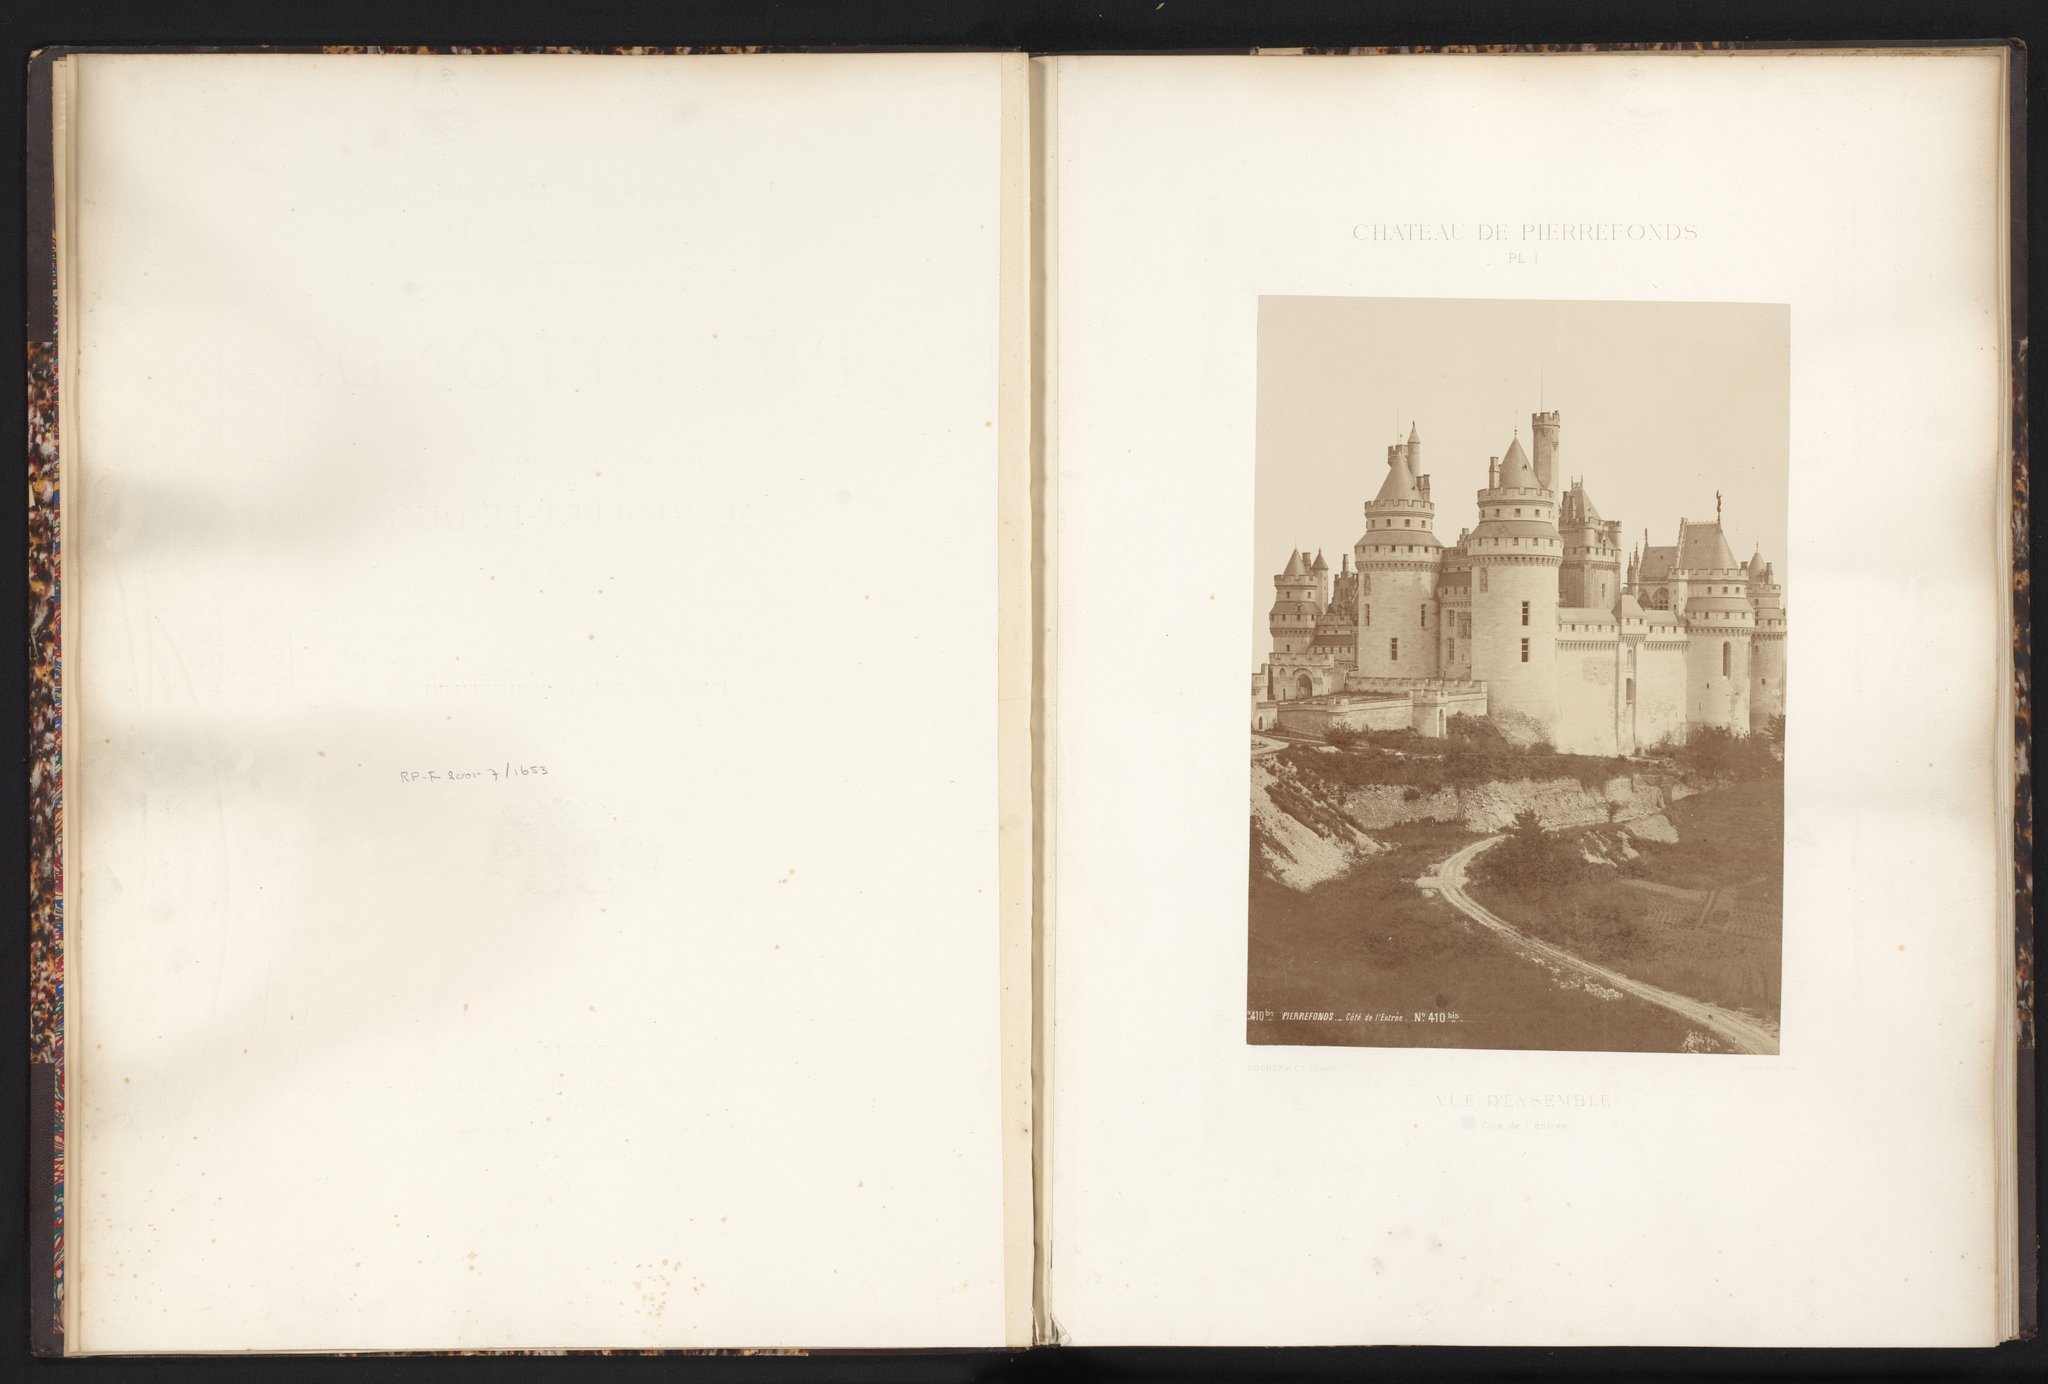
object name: page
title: Chateau de Pierrefonds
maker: séraphin-médéric mieusement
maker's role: fotograaf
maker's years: 1840-1905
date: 1870-1875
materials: photographic support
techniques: albumen print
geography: pierrefonds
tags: castle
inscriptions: inscription: ‘[No.] 410bis PIERREFONDS. - Côté de l'Entrée. No. 410bis.’, number: ‘PL. 1’